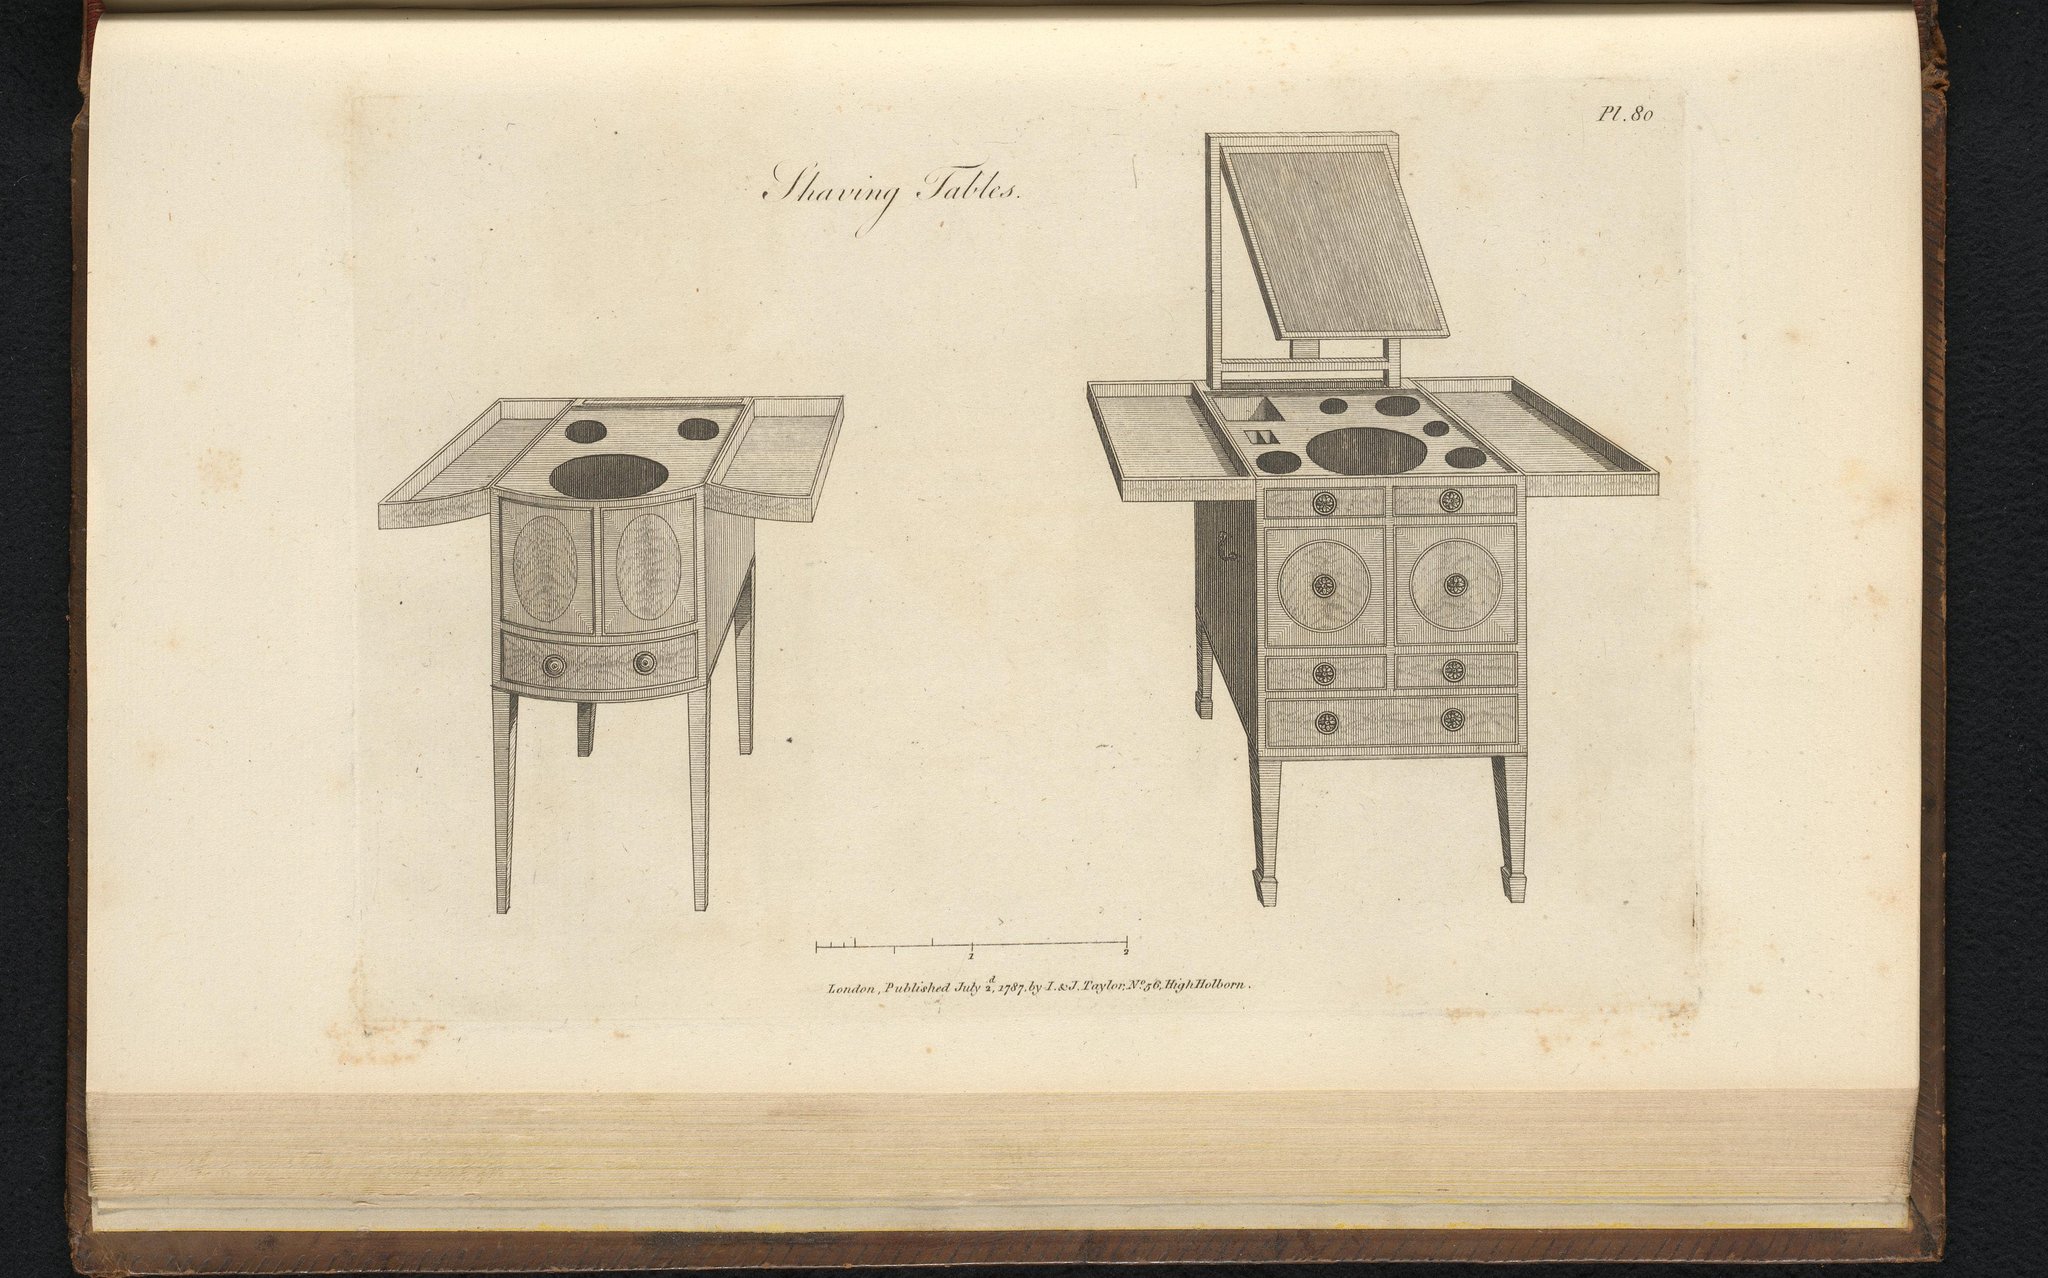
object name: page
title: Shaving Tables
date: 1787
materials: paper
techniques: engraving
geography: holborn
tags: table, shaving, being shaved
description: Genummerd: Pl. 80. Schaalverdeling in de ondermarge. Prent maakt deel uit van een boek.